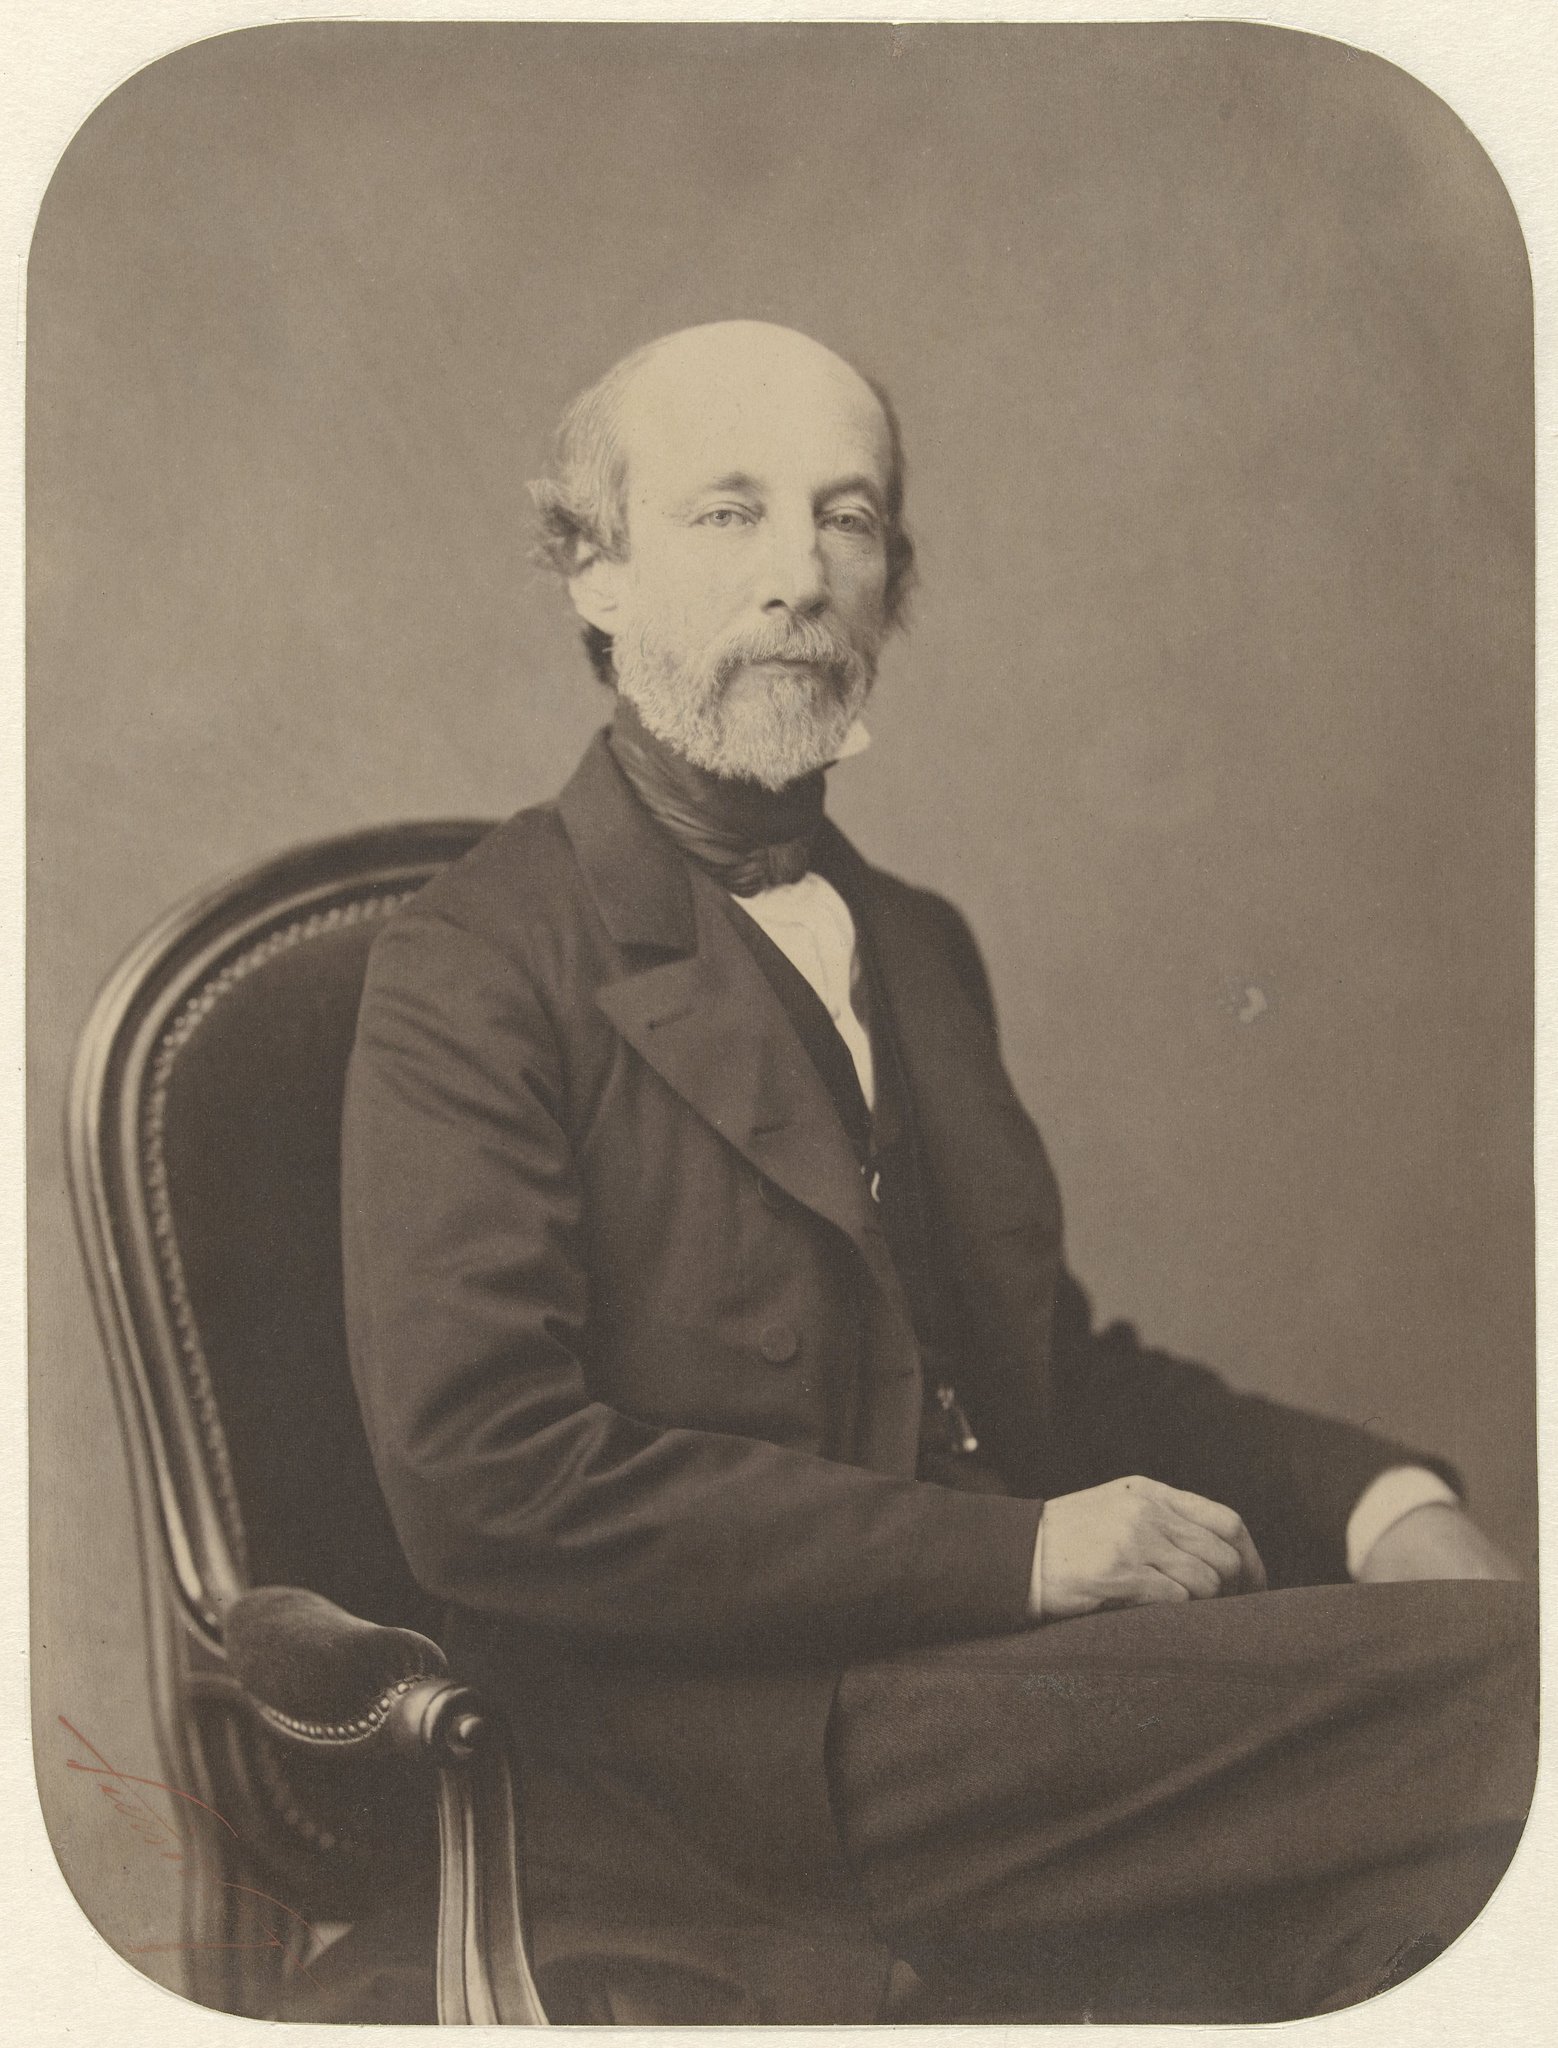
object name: photograph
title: Portret van Alfred de Falloux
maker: pierre petit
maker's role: fotograaf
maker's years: 1832-1909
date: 1855-1860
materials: cardboard, paper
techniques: salted paper print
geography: paris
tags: politician, alfred de falloux, historical persons, politician, e.g. party leader, paris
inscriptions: signature: ‘Pierre Petit’, annotation: ‘M. Falloux’